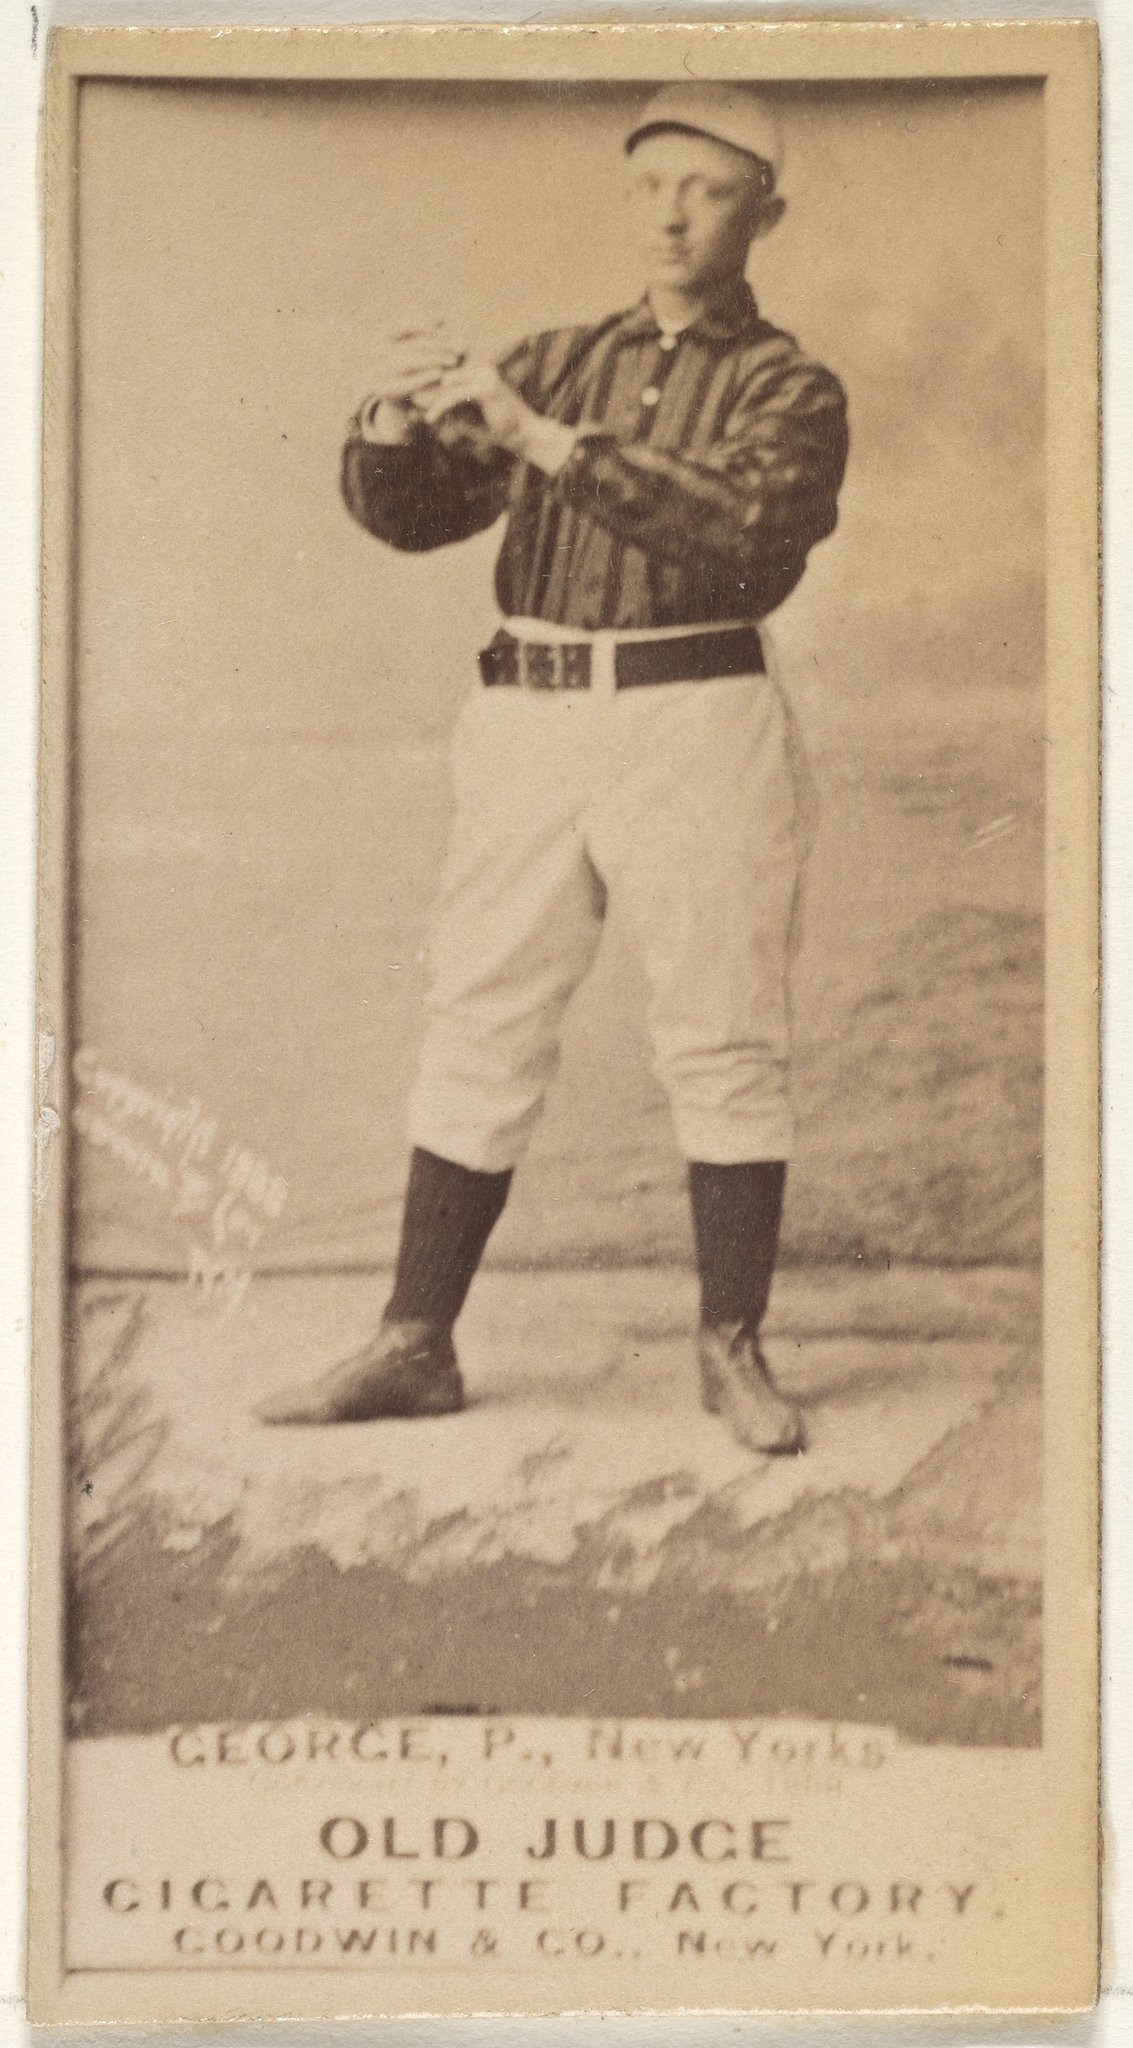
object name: baseball card, photograph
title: Bill George, Pitcher, New York, from the Old Judge series (N172) for Old Judge Cigarettes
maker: goodwin & company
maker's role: publisher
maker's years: 1850-1950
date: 1888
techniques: albumen silver print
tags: men,portraits,baseball,athletes